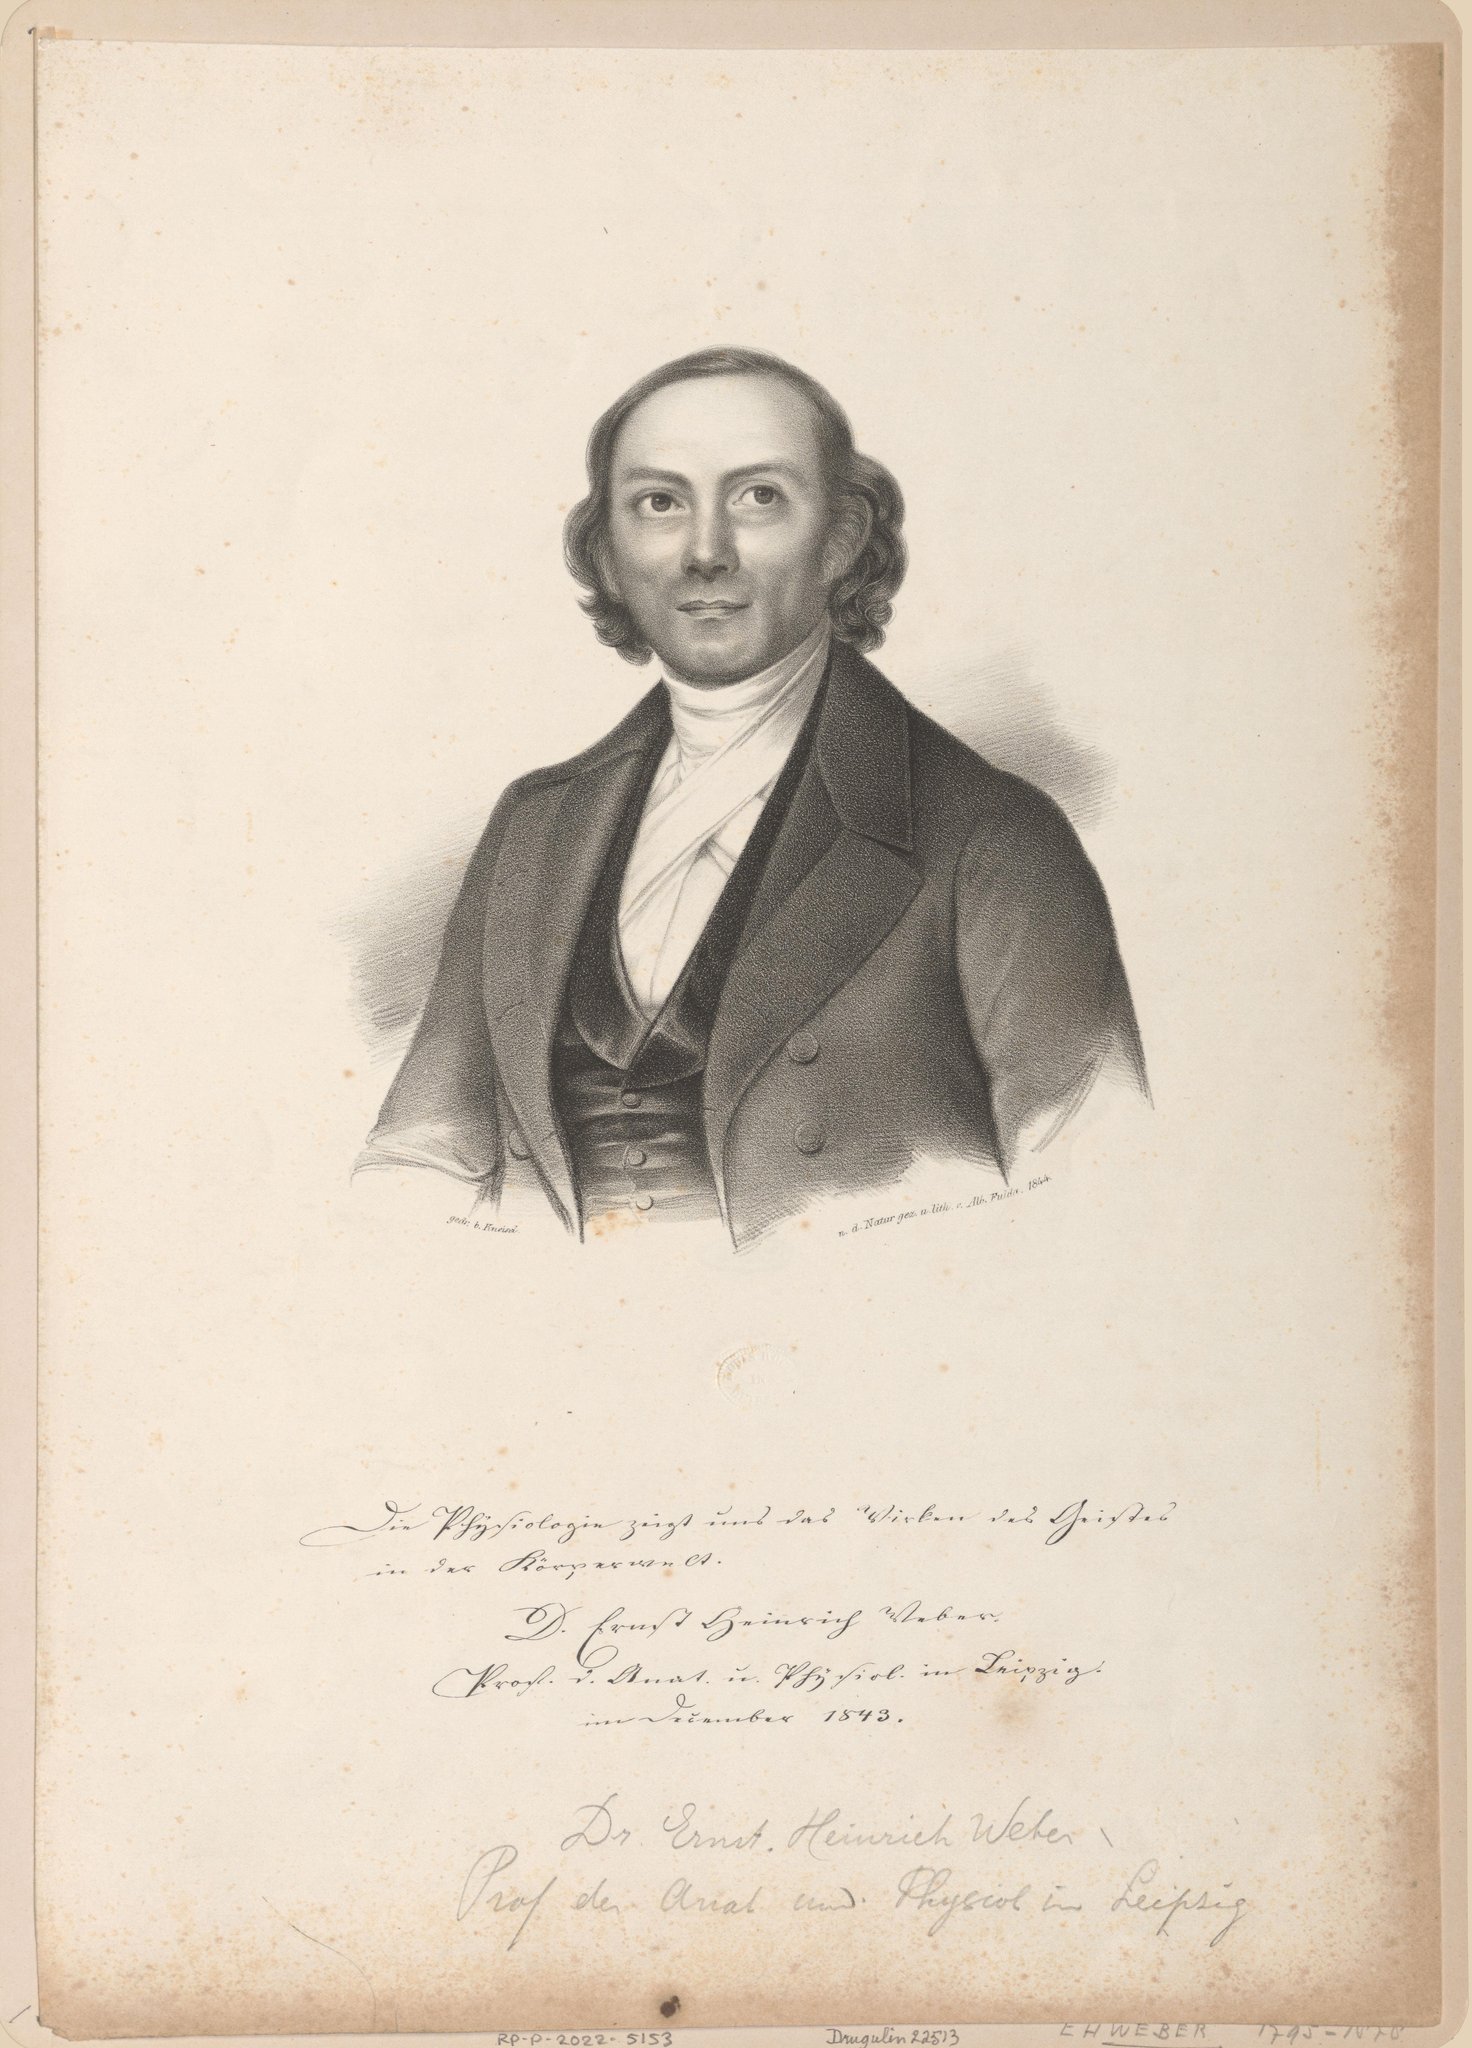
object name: print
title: Portret van Ernst Heinrich Weber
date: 1844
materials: paper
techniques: lithograph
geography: leipzig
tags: historical persons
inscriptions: stamp: ‘Louis Rocca in Leipzig’